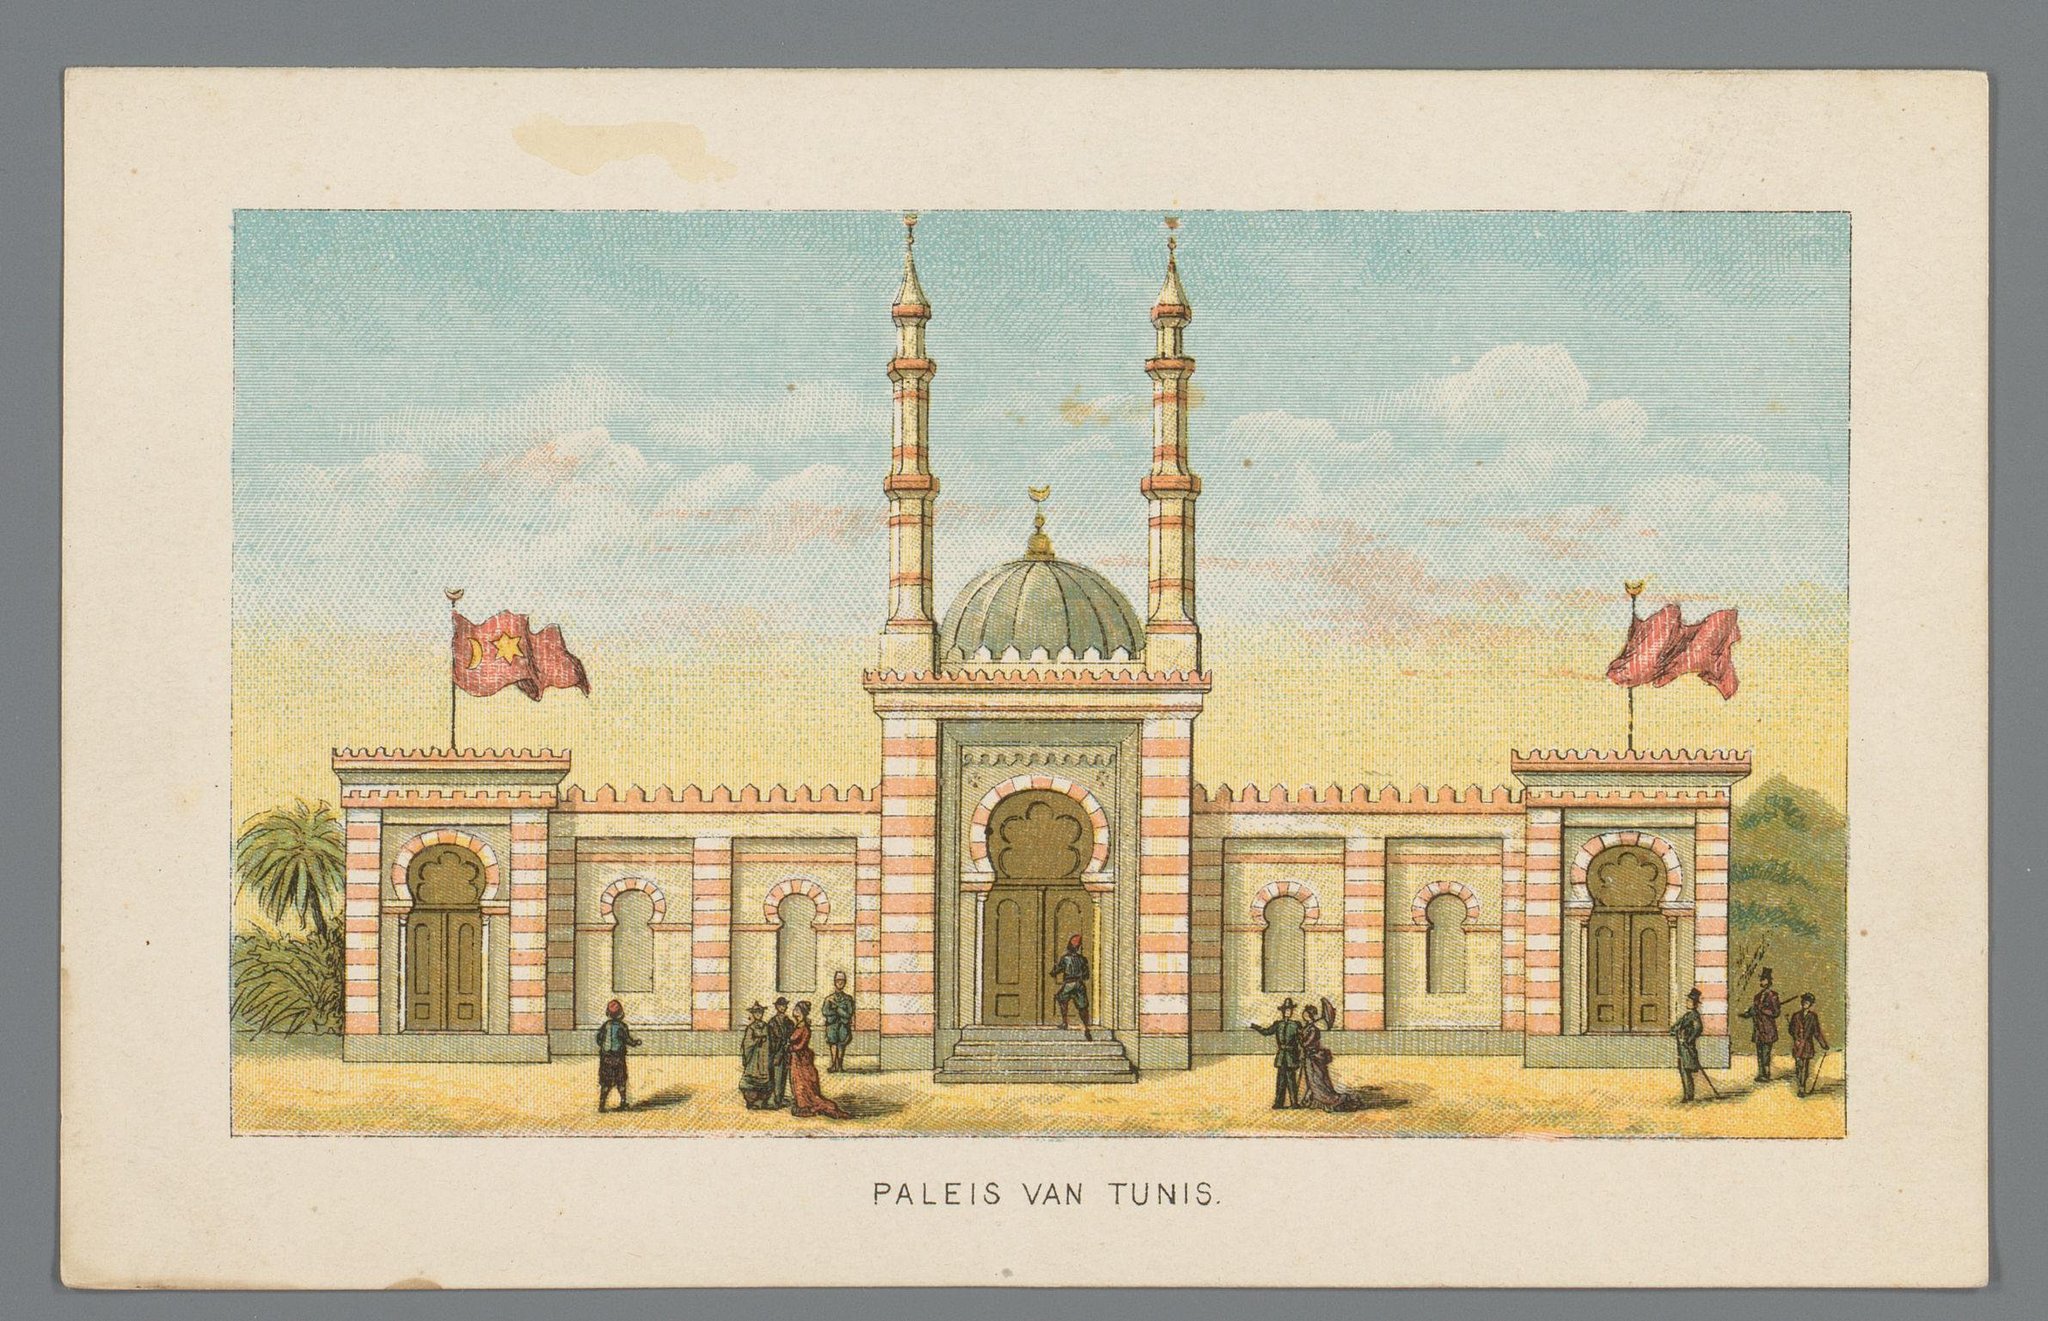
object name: print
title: Paleis van Tunis op de Wereldtentoonstelling in Amsterdam, 1883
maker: Anonymous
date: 1883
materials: paper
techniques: chromolithography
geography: amsterdam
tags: world fair, world exhibition, amsterdam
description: Deze prent komt voor in: Herinnering aan Amsterdam in 1883. Amsterdam: Het Nieuws van den Dag, 1883. Dit is een serie van zestien prenten over de wereldtentoonstelling in Amsterdam, 1883, met daarbij een plattegrond van het tentoonstellingsterrein en een omslag.